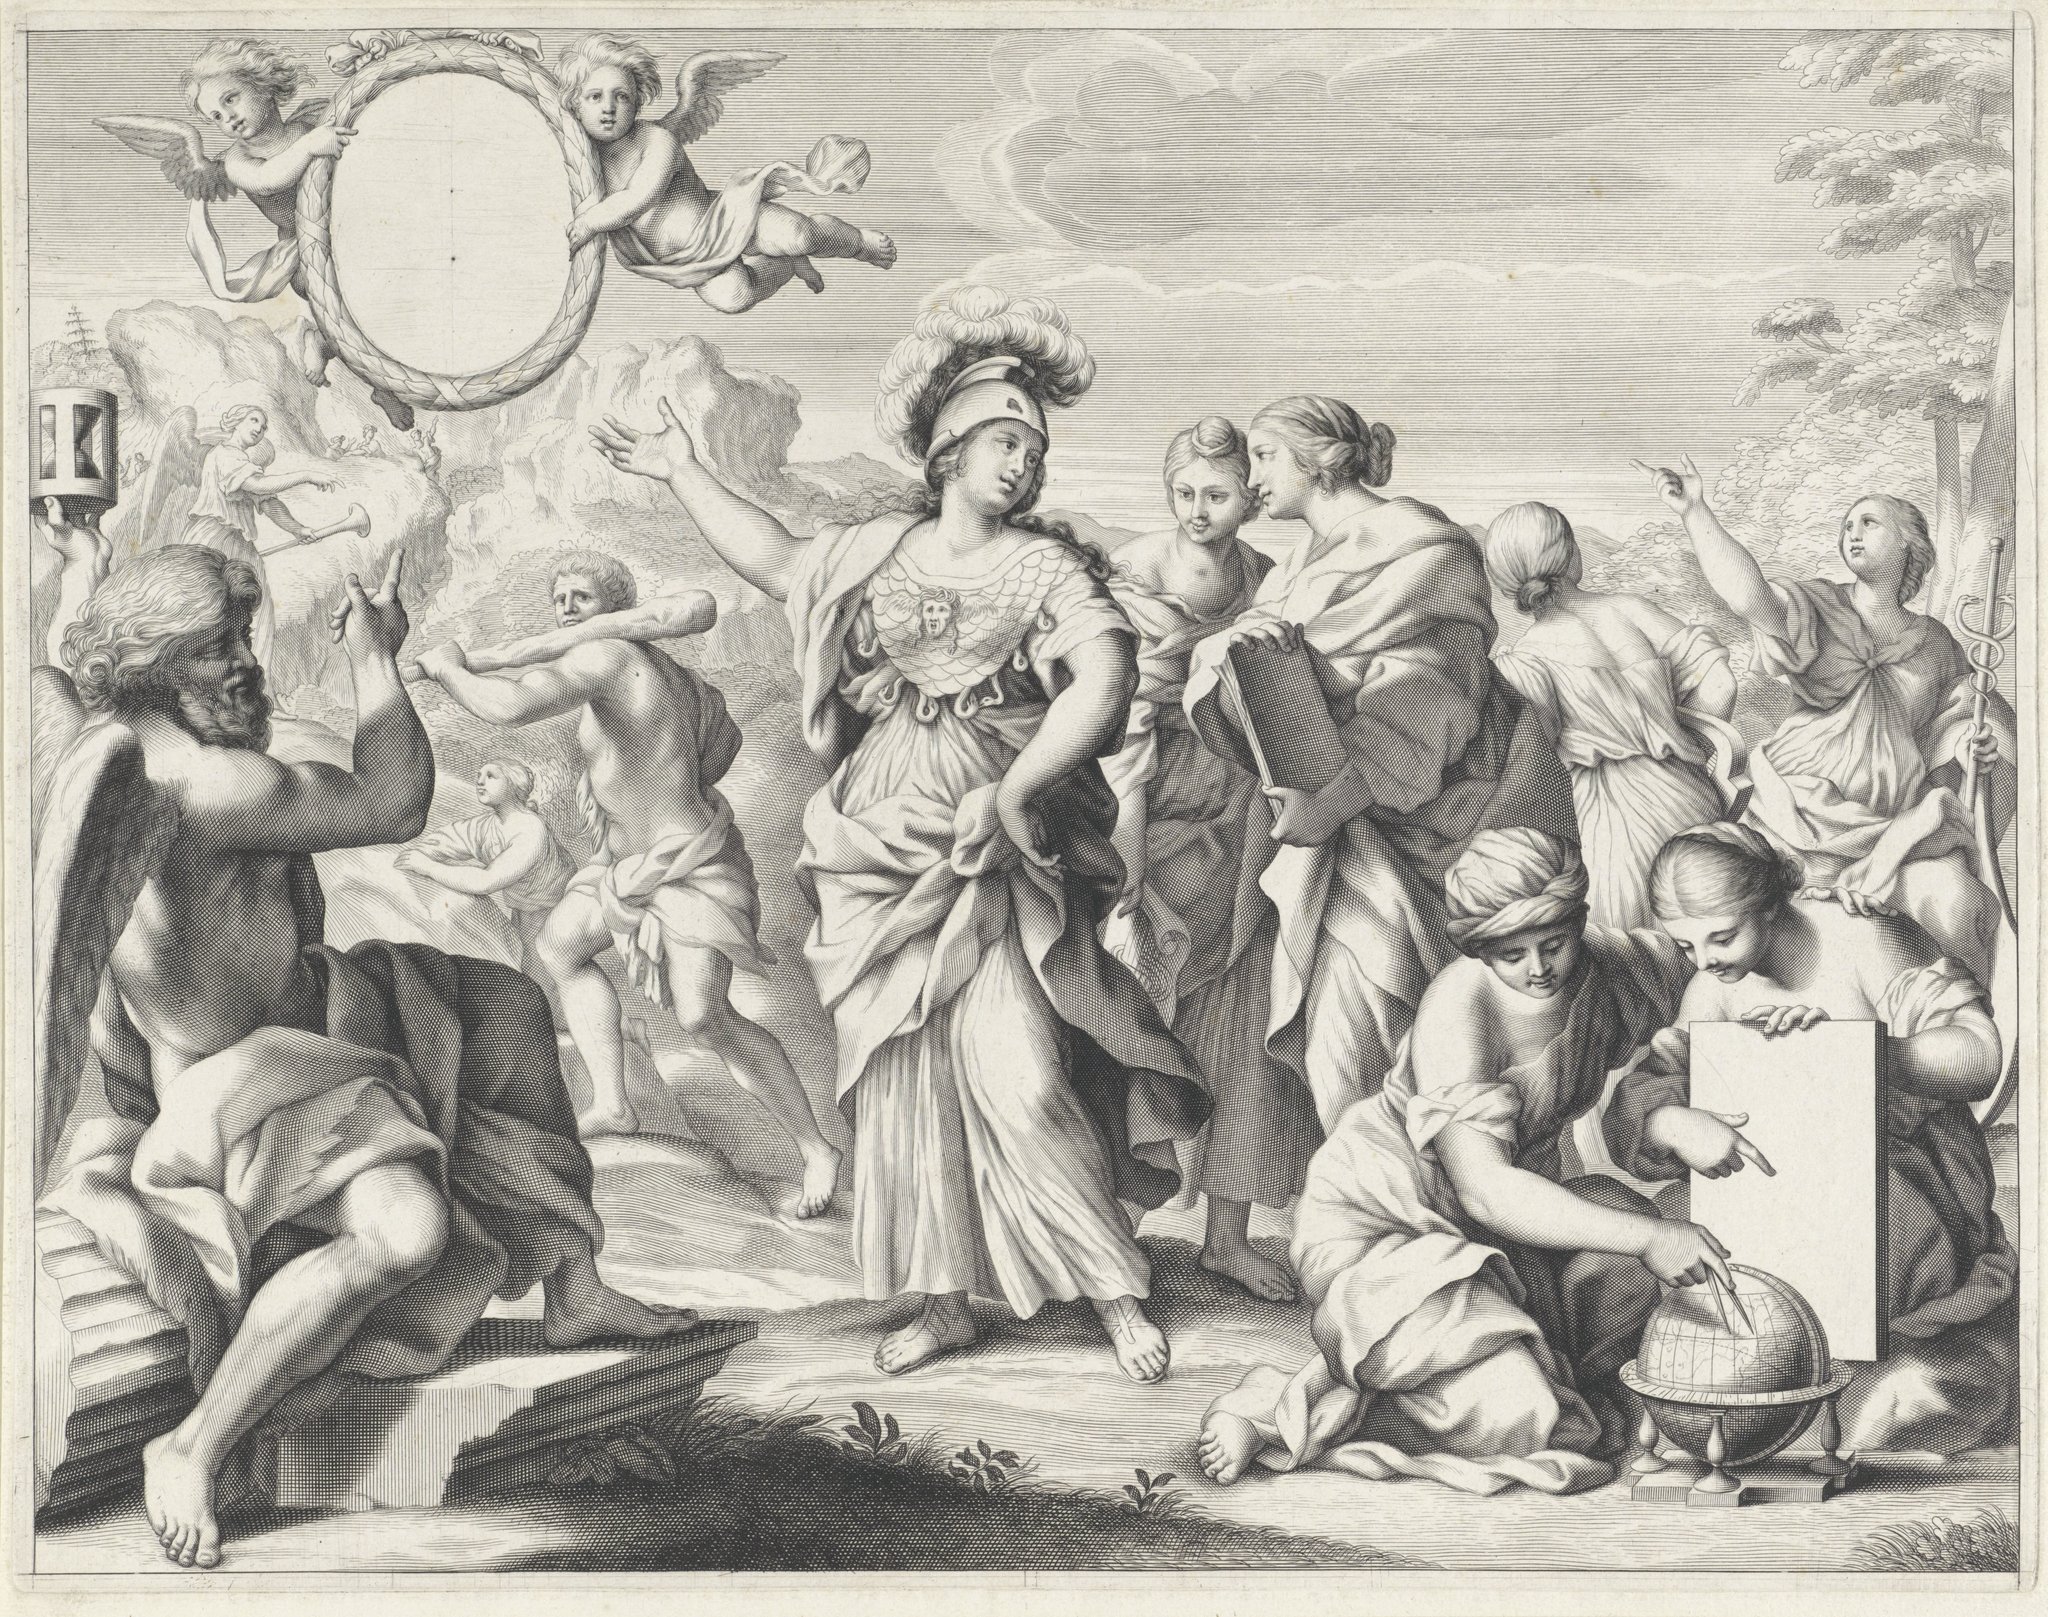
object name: print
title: Allegorie op de Deugd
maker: lambert visscher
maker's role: draughtsman, print maker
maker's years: 1640-1679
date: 1643-1690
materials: paper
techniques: engraving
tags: (story of) hercules (heracles), (story of) minerva (pallas, athena), compasses, globe, cupids: 'amores', 'amoretti', 'putti', father time, man with wings and scythe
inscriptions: collector's mark: Lugt 240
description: Minerva en Vader Tijd wijzen op de berg van Deugd op de achtergrond. Hercules wijst de weg. Rechts op de voorgrond bestuderen twee vrouwen een globe.